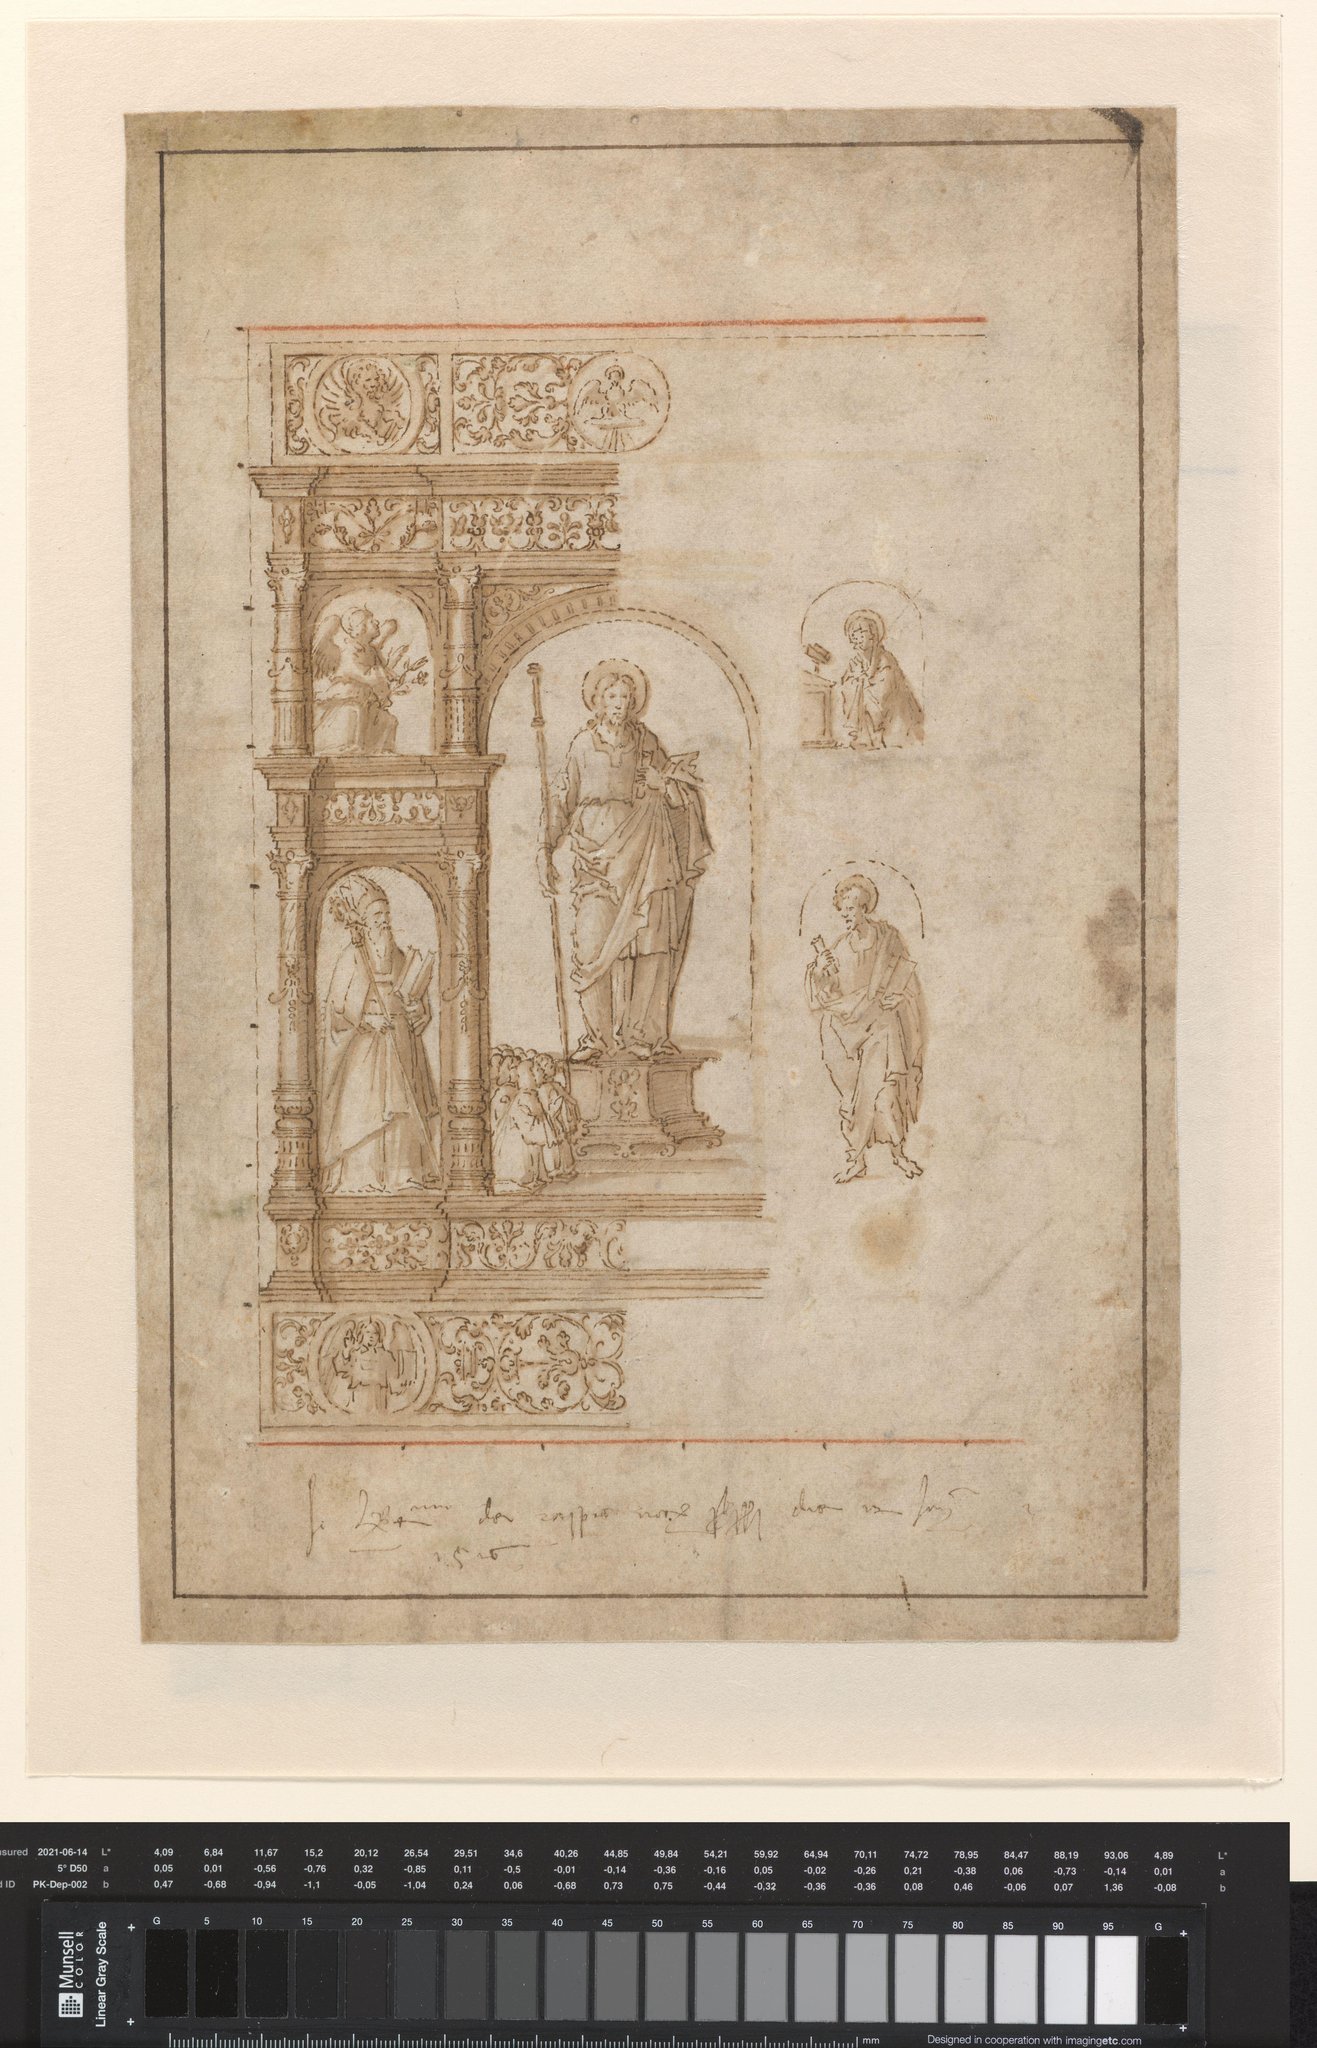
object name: drawing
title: Ontwerp voor een altaarstuk met vijf compartimenten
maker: girolamo da santacroce (ca.1480-1556)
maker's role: draughtsman, painter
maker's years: 1480-1556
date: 1490-1556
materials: chalk, ink, parchment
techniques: brush, pen